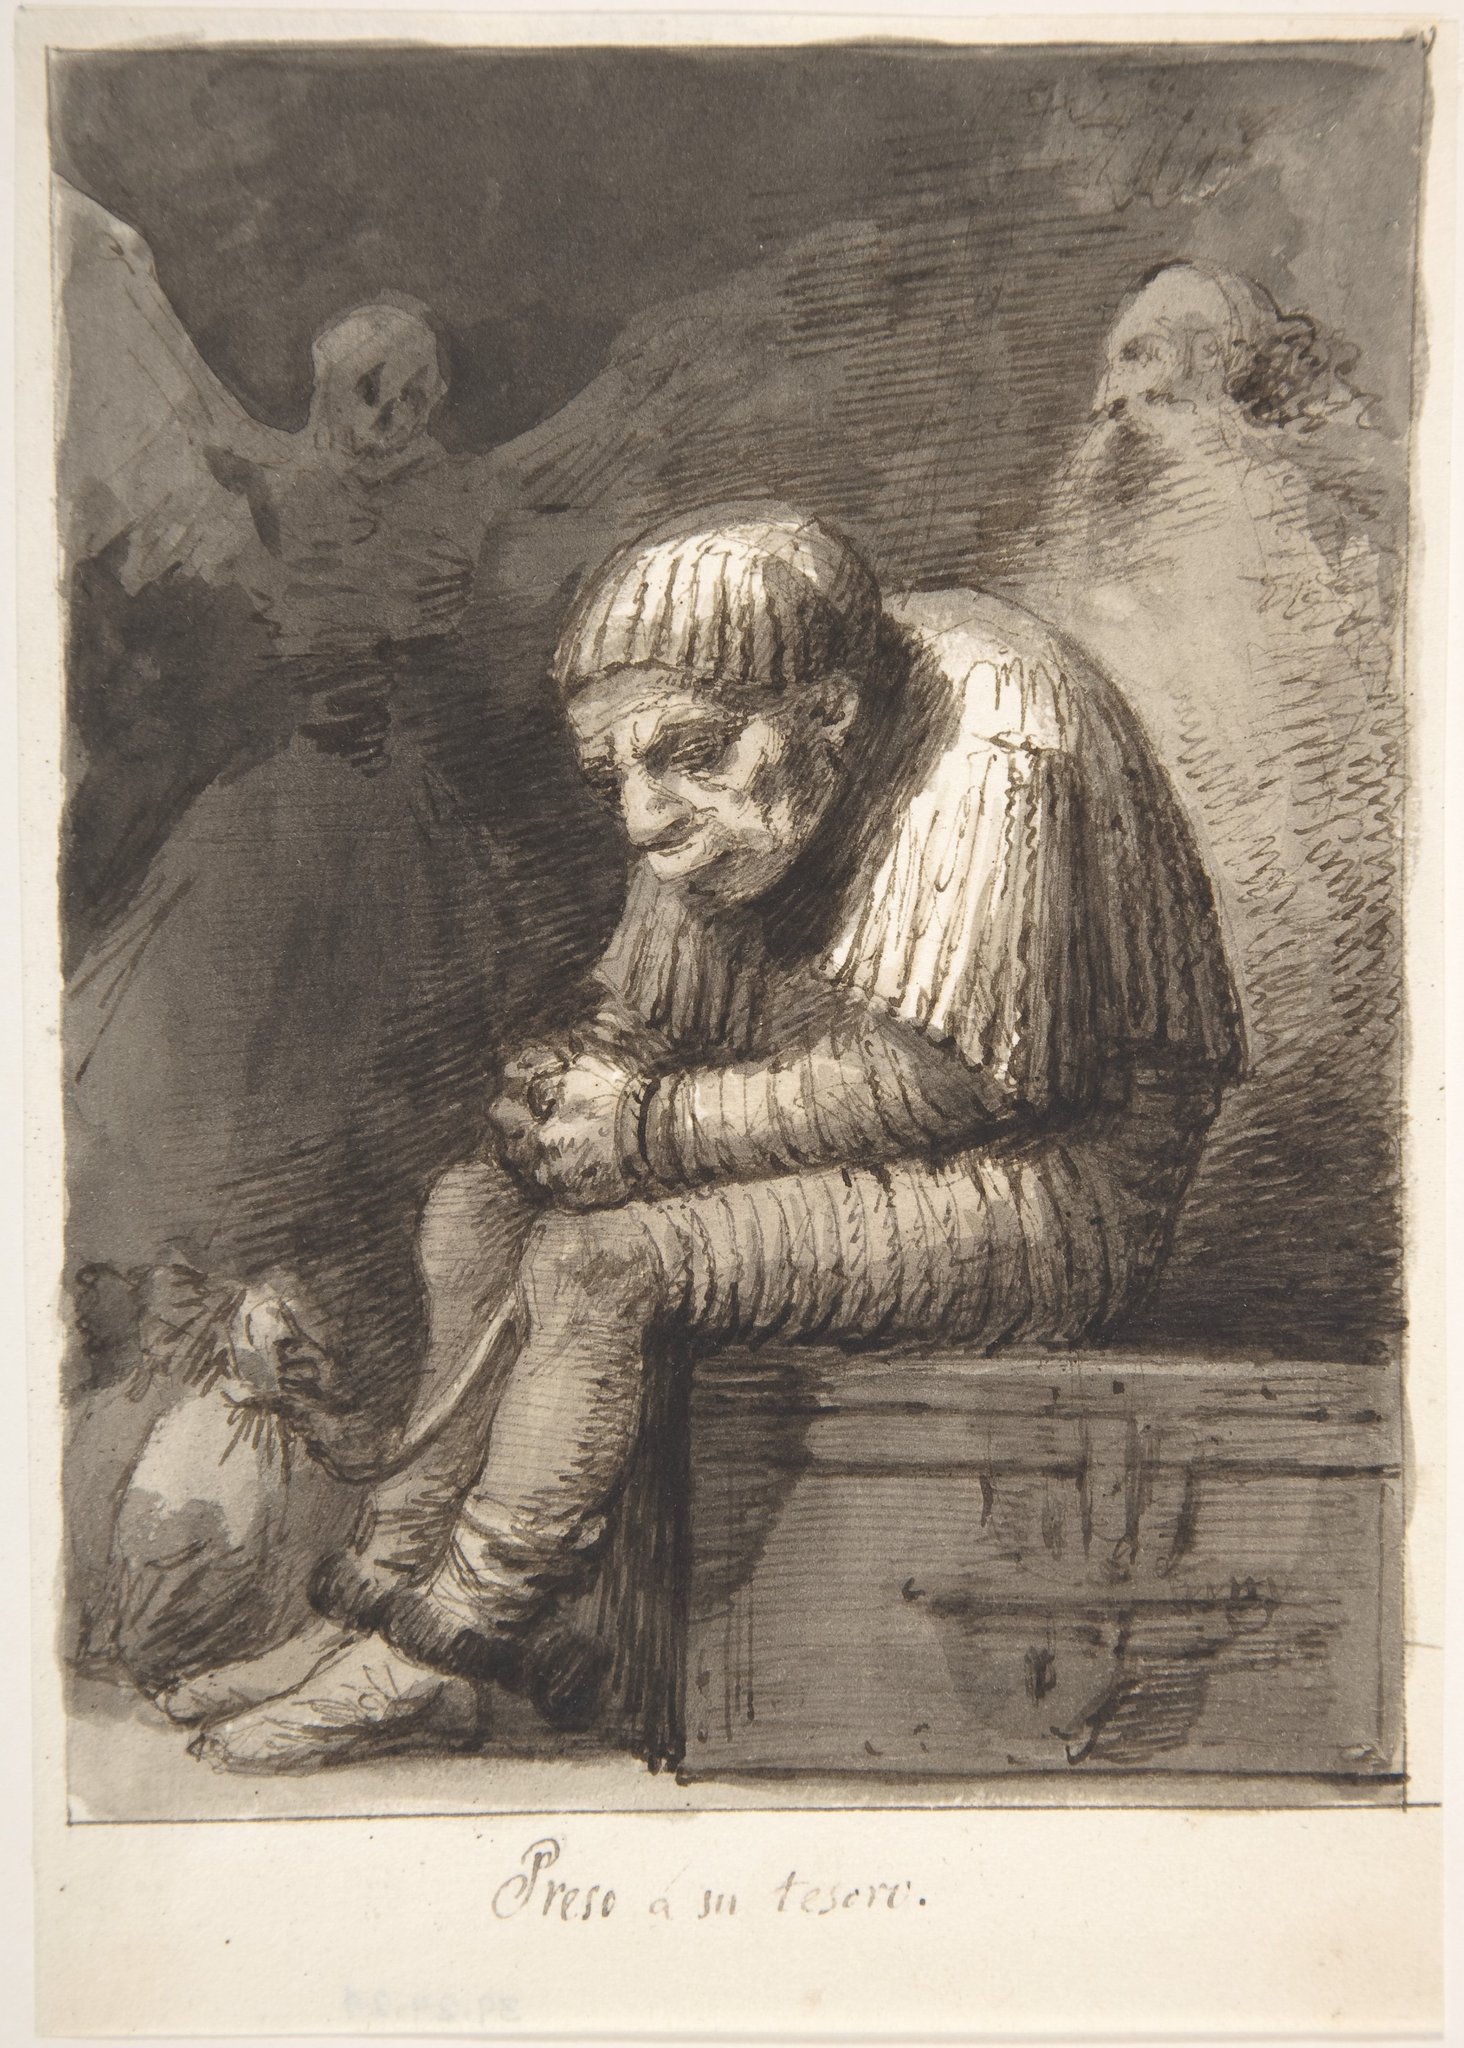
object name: drawing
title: Shackled to His Treasure (Preso á su tesoro)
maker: leonardo alenza y nieto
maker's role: artist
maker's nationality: spanish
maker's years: 1807-1845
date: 1807-1845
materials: ink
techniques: brush, pen, wash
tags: human figures